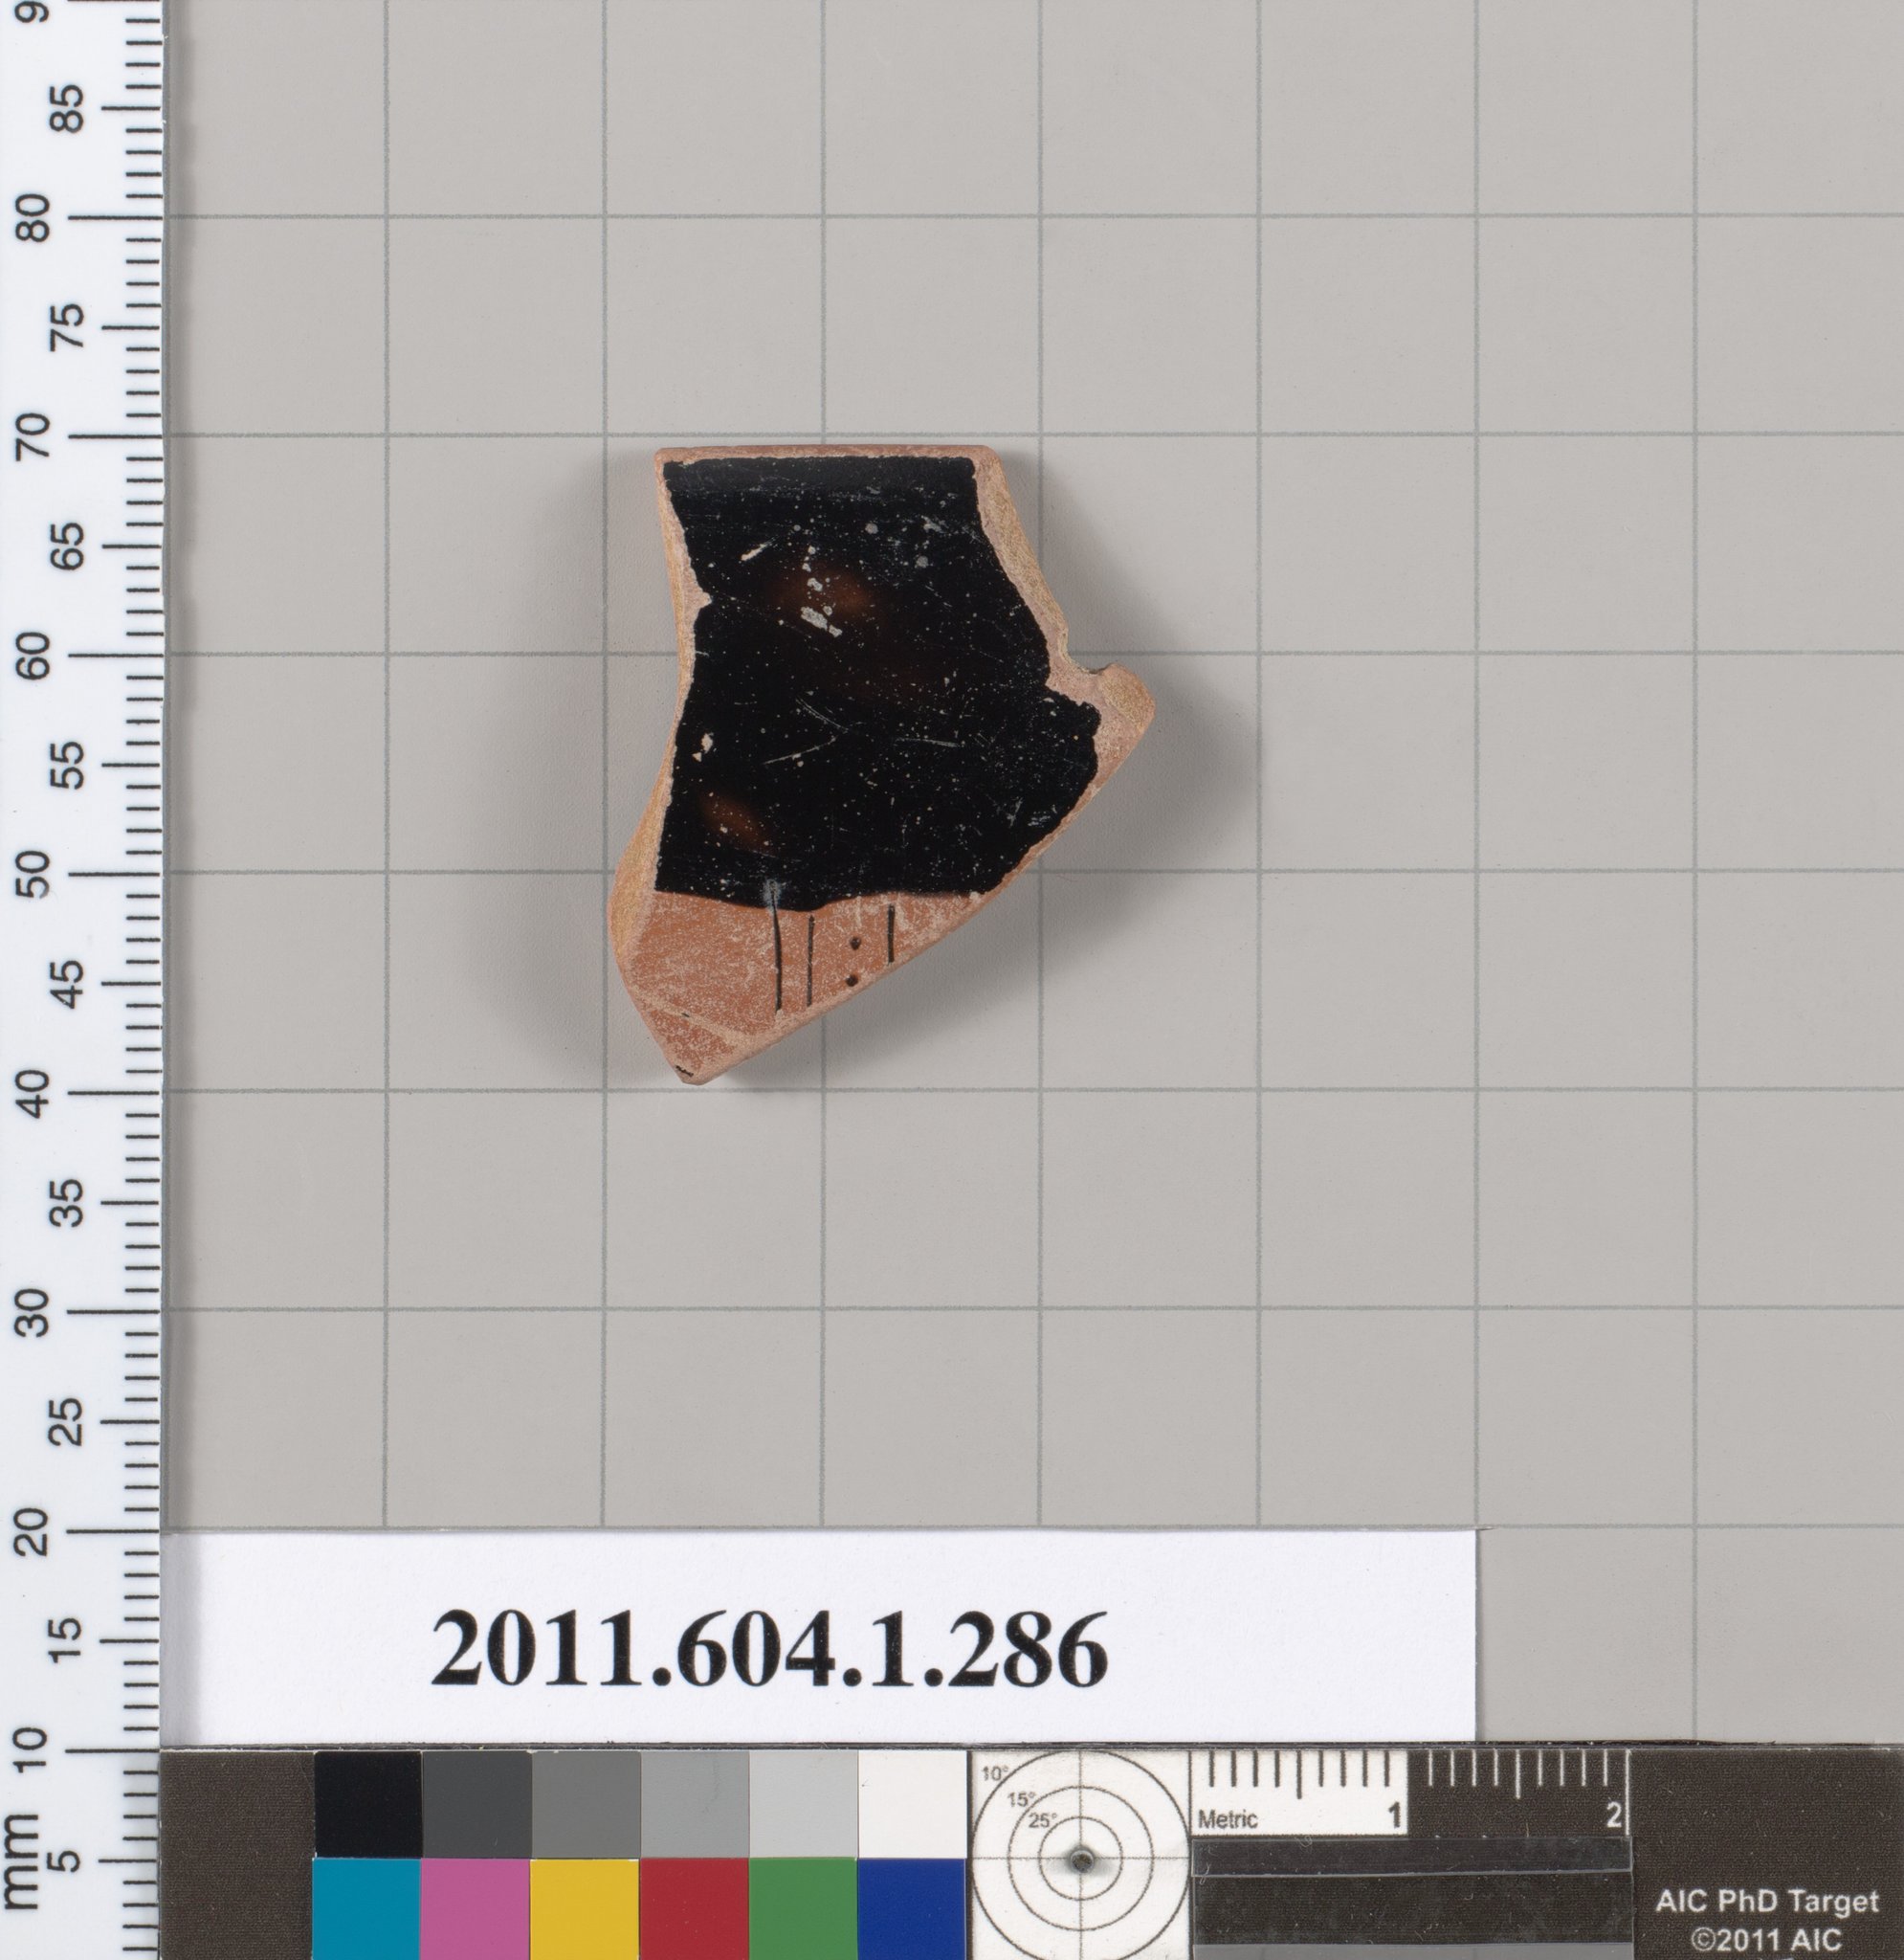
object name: kylix fragment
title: Terracotta rim fragment of a kylix (drinking cup)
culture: greek, attic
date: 475-451 BCE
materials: terracotta